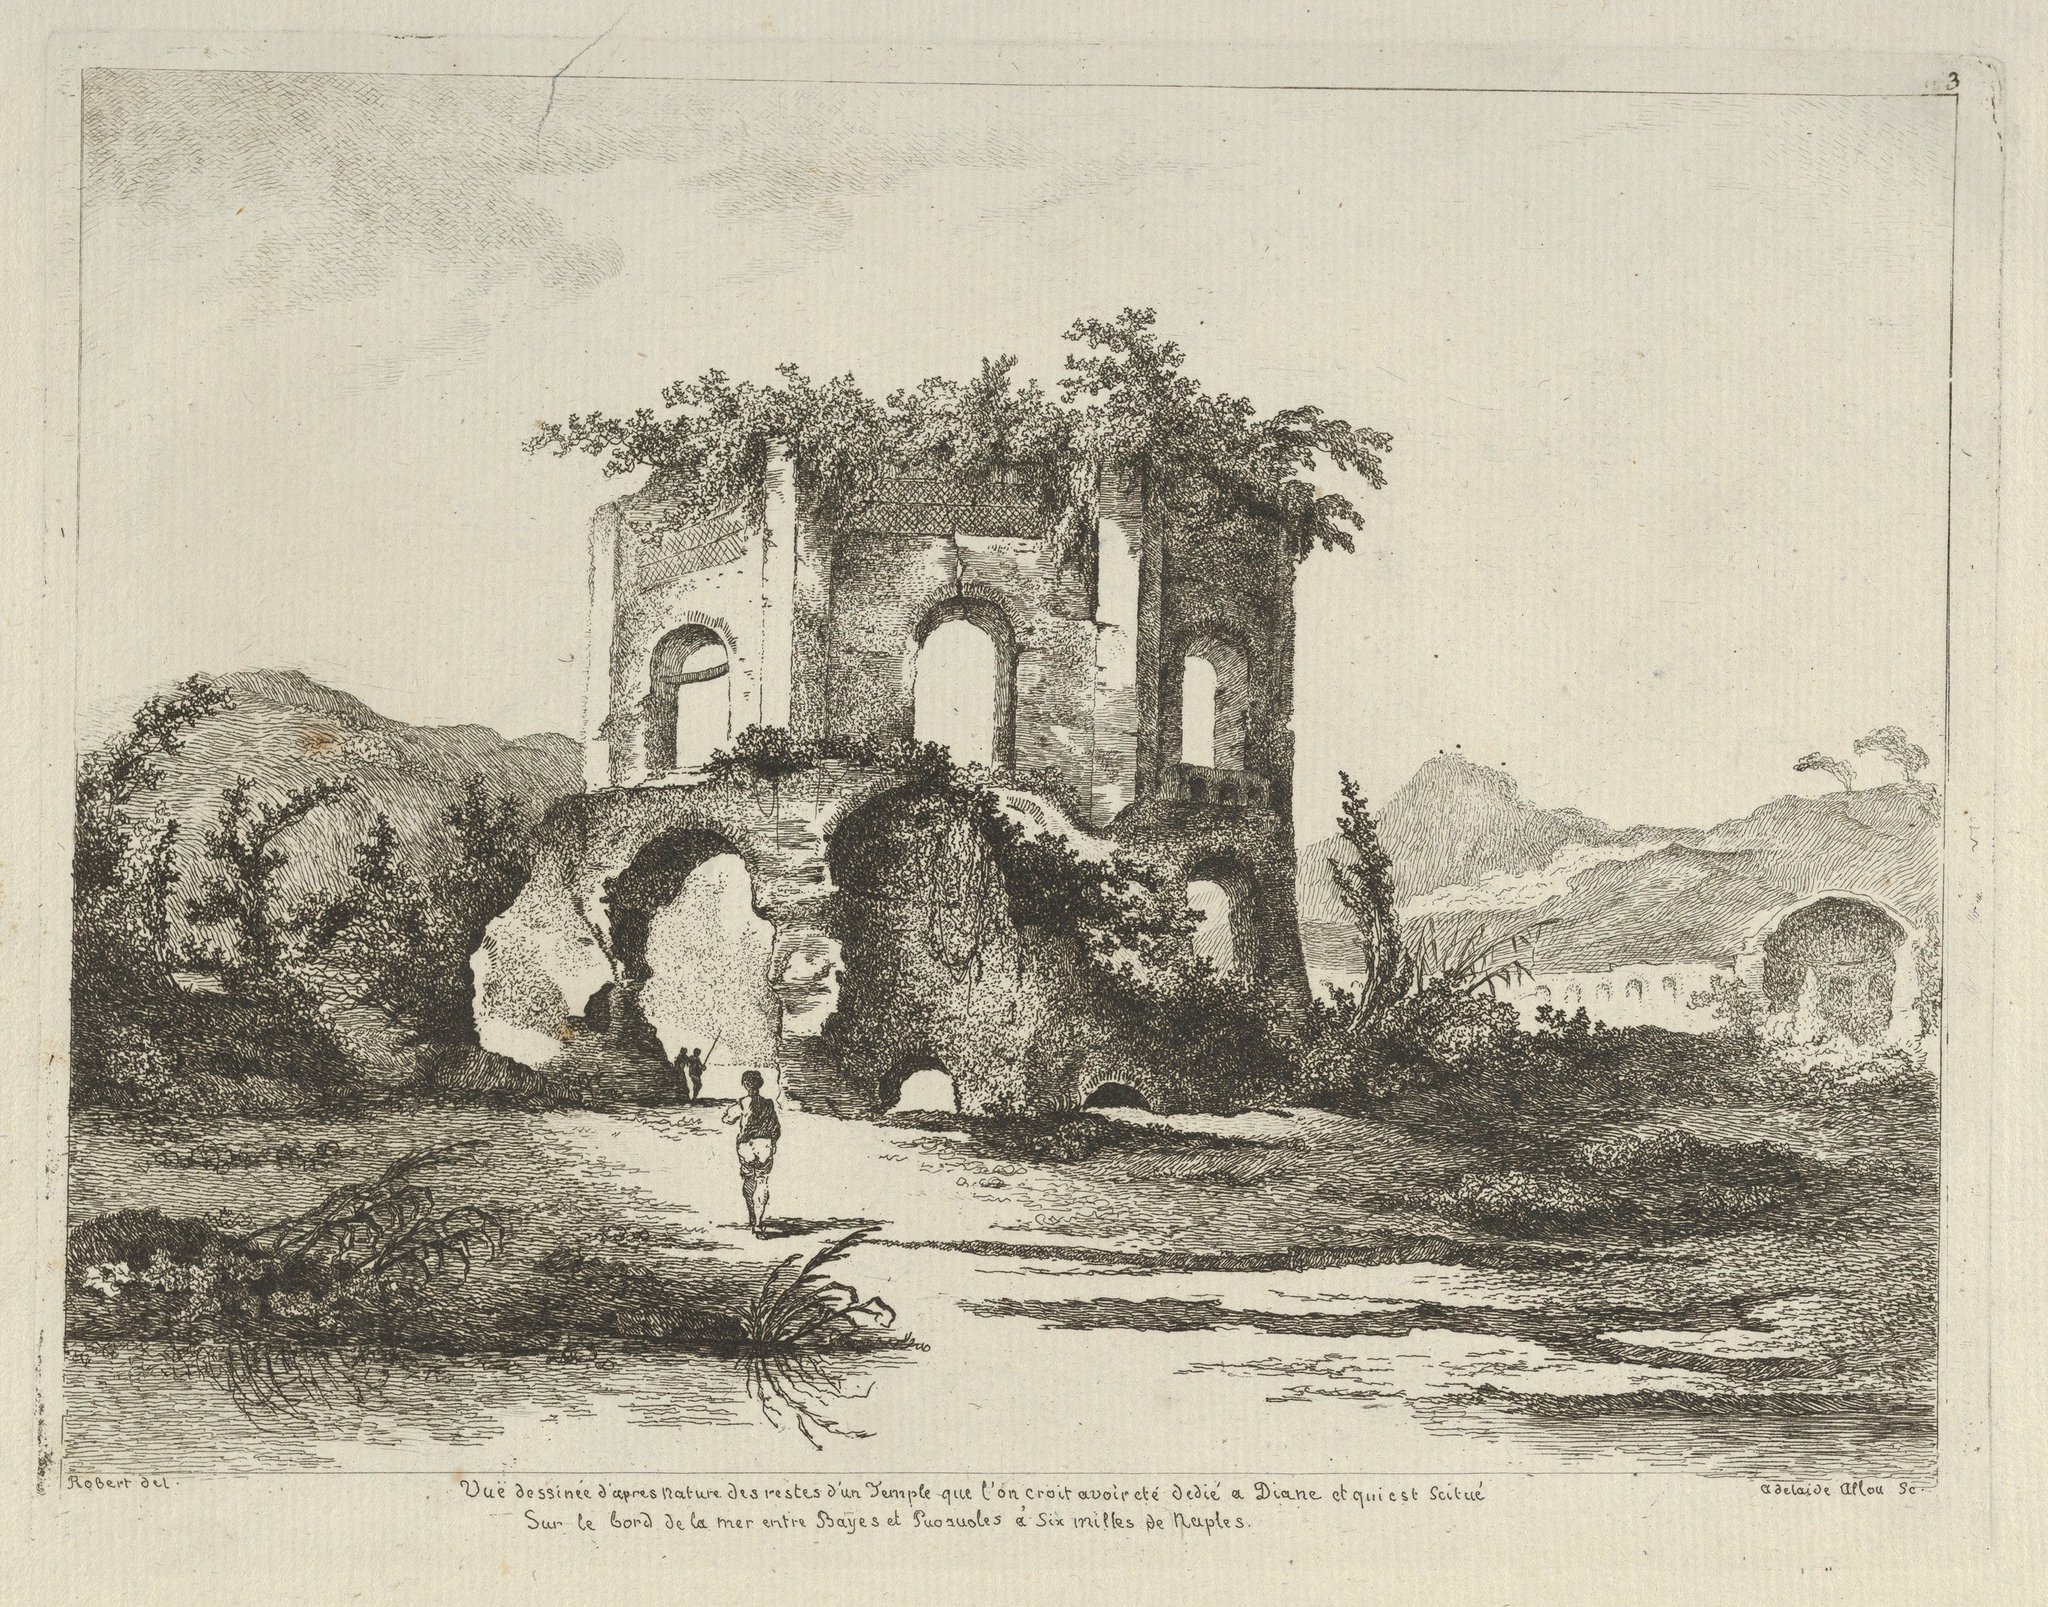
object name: print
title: Vue d'un temple... dédié à Diane from Differentes vues dessiné d'après nature... dans les environs de Rome et de Naples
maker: adélaide allou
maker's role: artist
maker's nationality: french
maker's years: 1776-1800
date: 1701-1800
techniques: etching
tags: ruins,landscapes